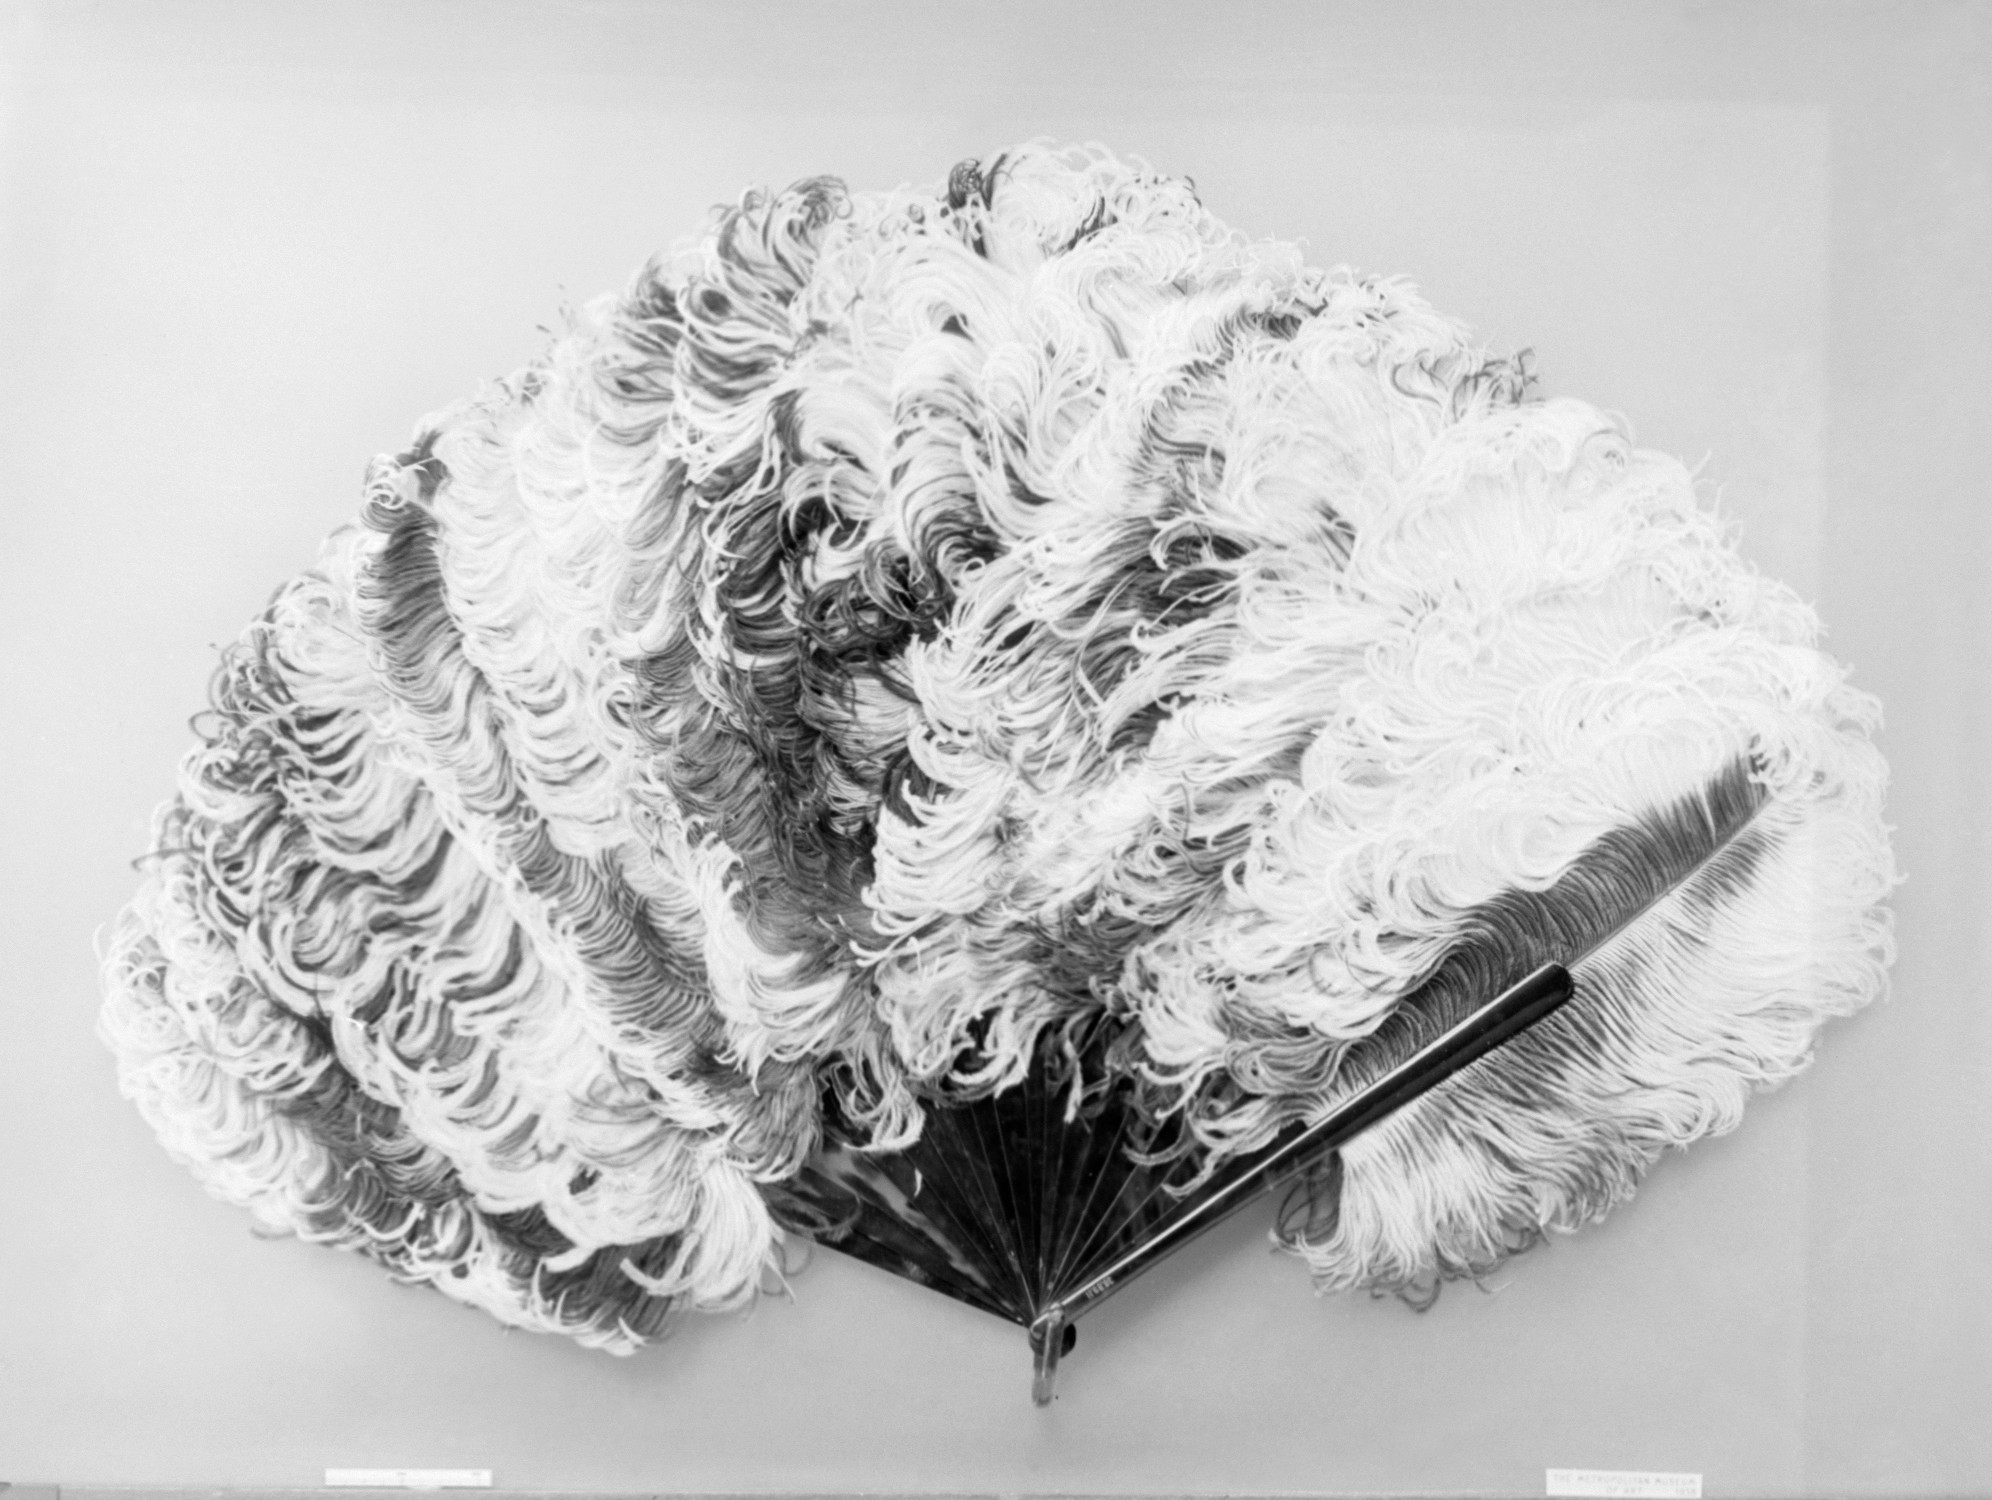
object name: fan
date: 1867-1900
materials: feather, shell